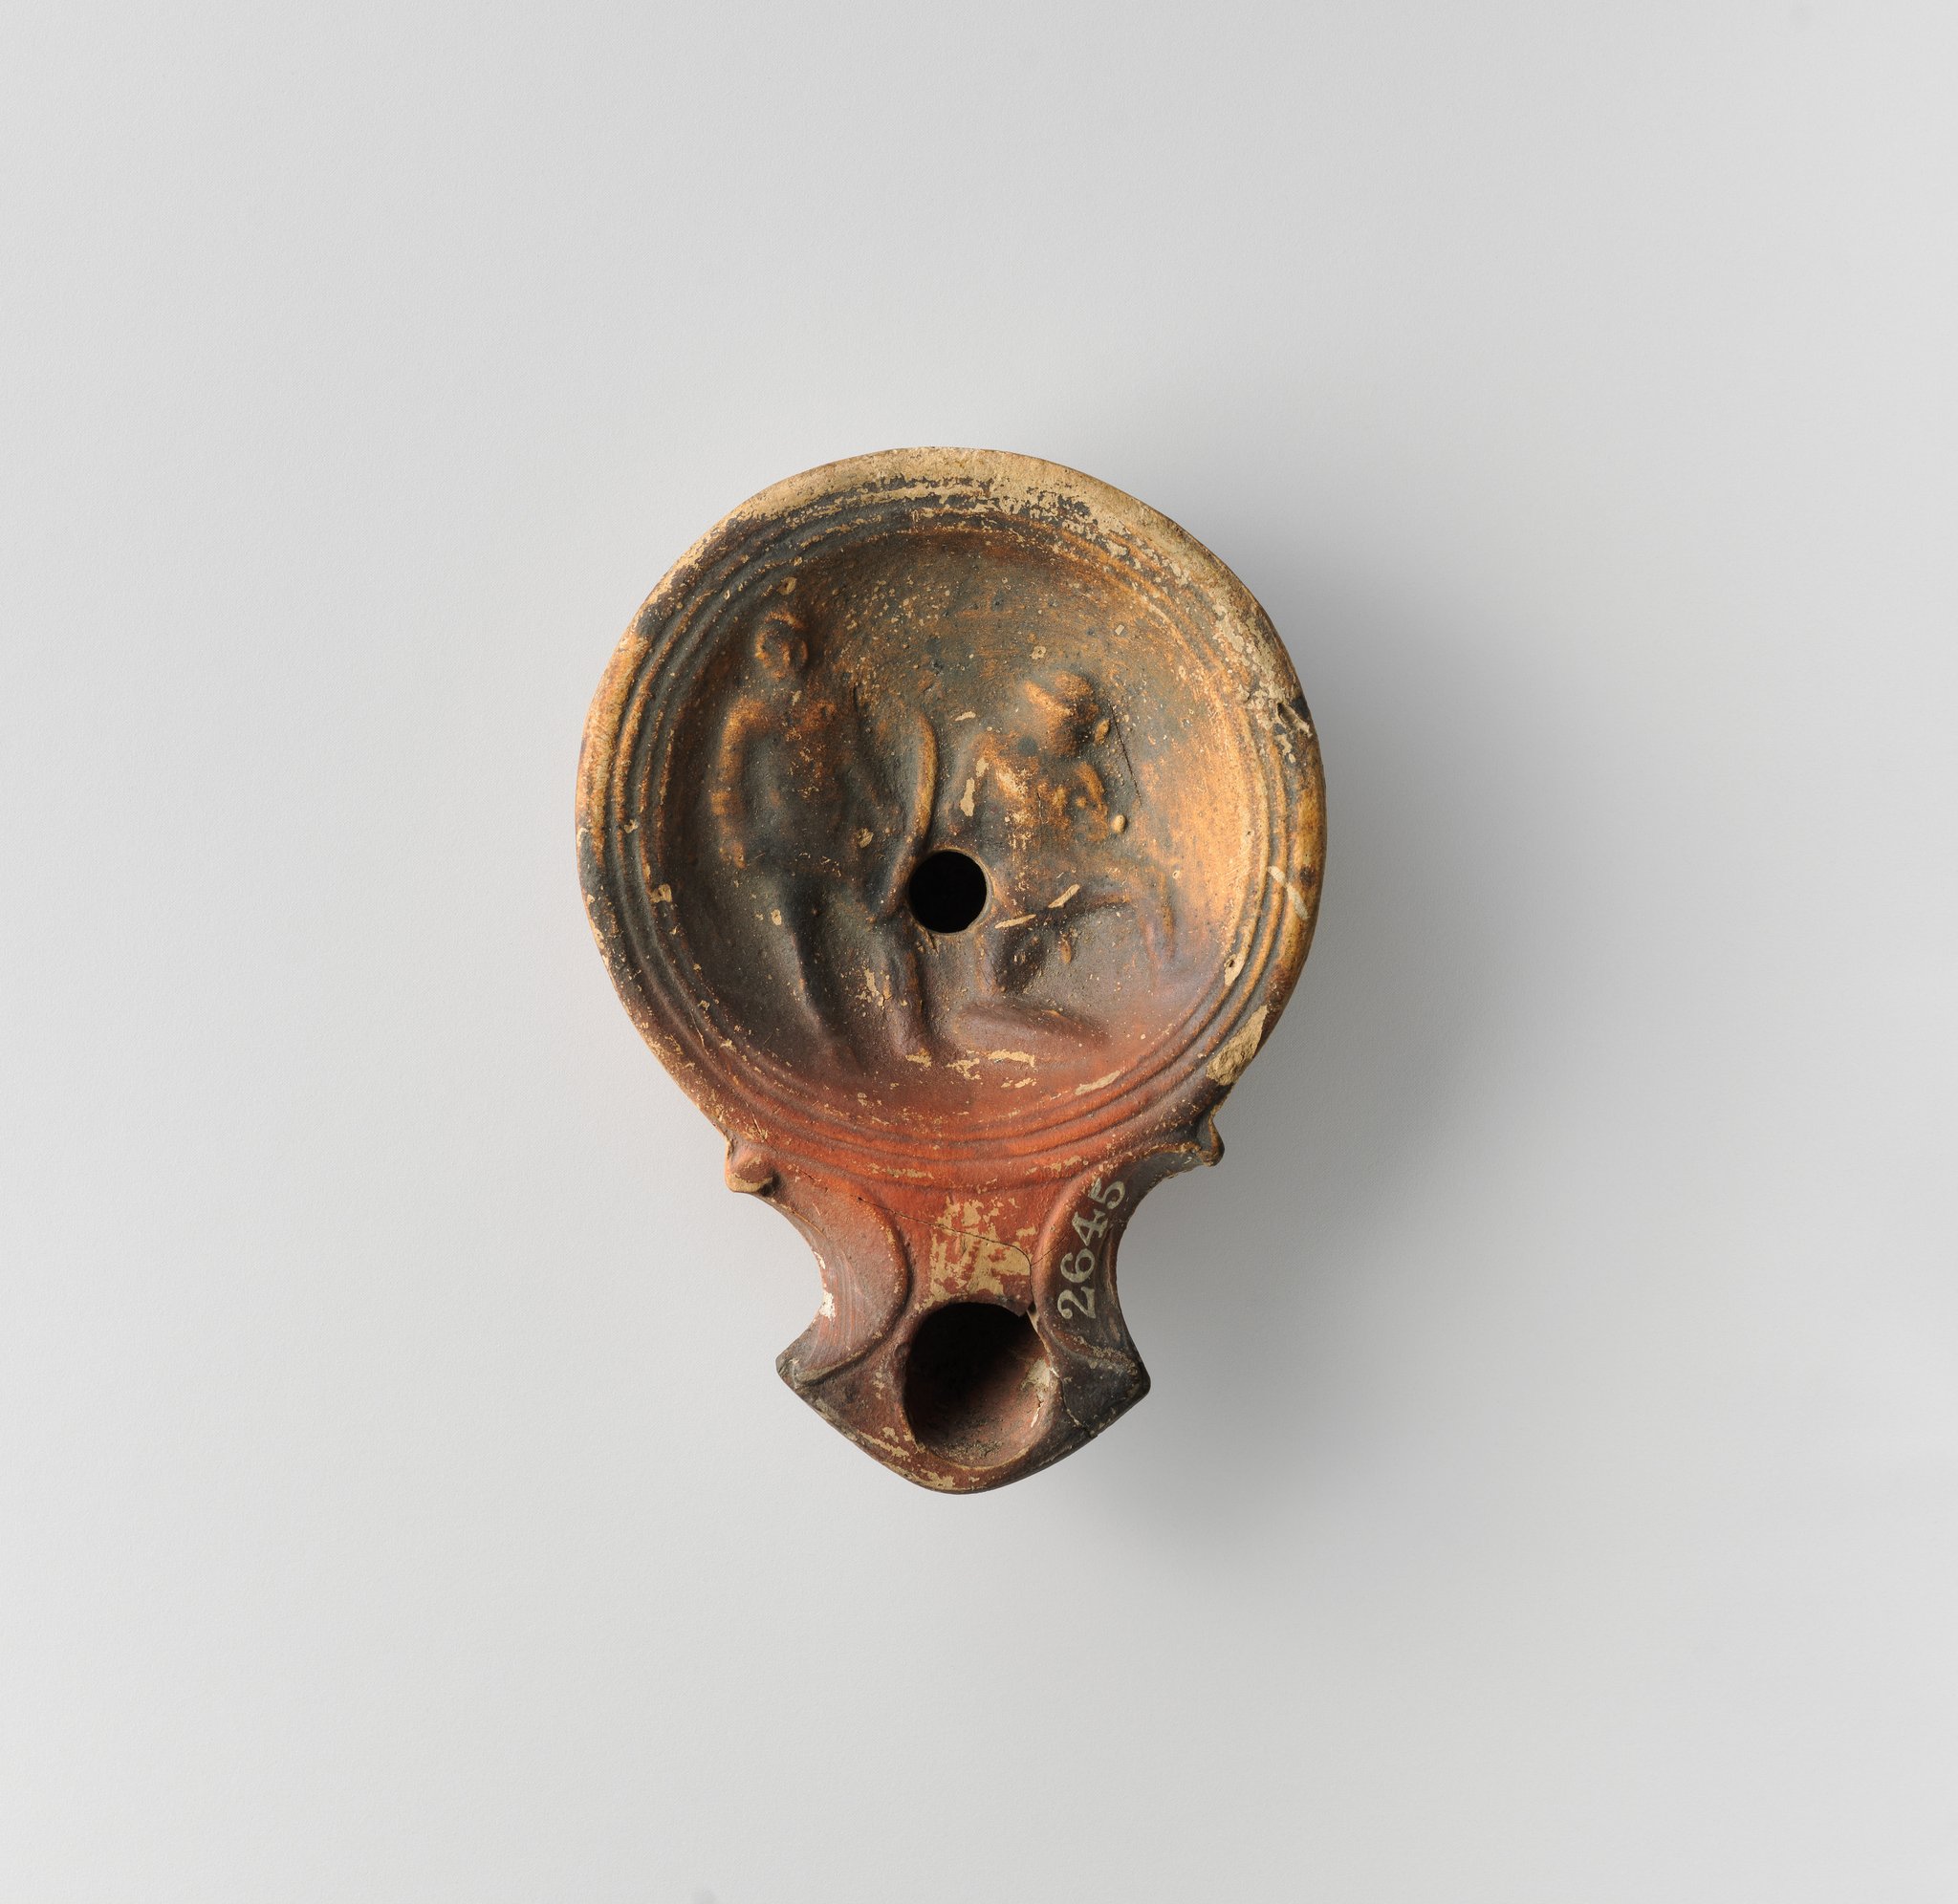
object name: lamp, concave top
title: Terracotta oil lamp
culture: cypriot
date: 100 BCE-100 CE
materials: terracotta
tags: gladiators